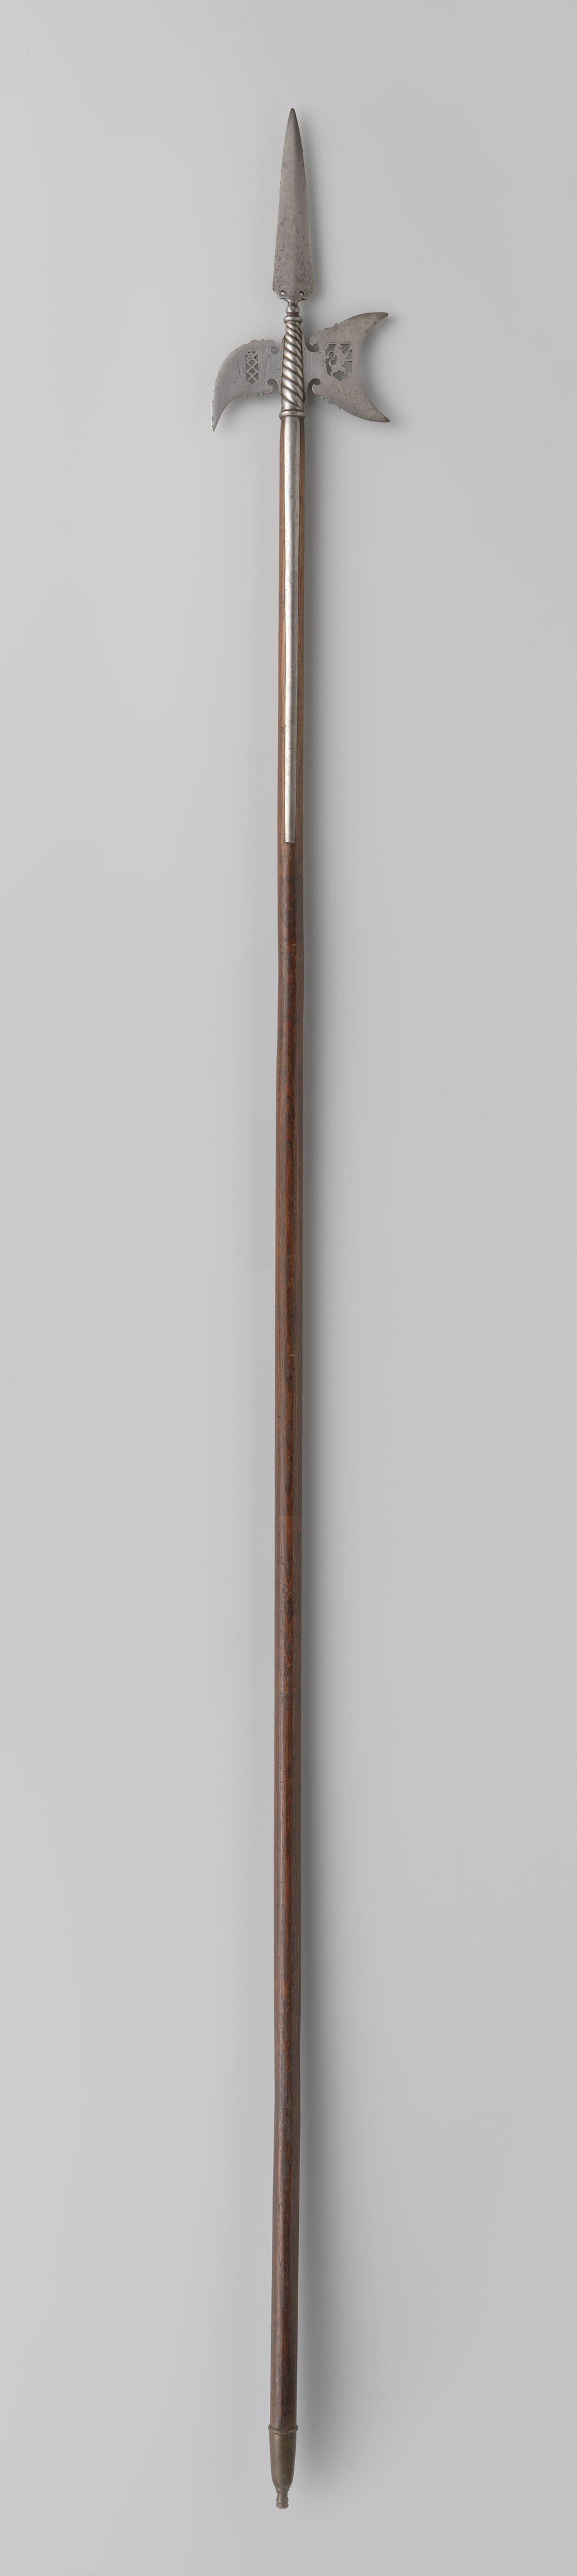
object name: halberd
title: Sergeantshellebaard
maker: Anonymous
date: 1600-1699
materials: iron, wood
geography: low countries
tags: europe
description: Korte kling met een sterke taps toelopende vorm; onderin twee doorboringen. Taps toelopend gedraaid huis met twee ringvormig profielen boven en onder. Het huis heeft een dwars doorgaande spleet waar de bijl en haak doorheen zijn gestoken. Zowel de bijl als de haak zijn ajourgewerkt. In de bijl is een primitieve staande leeuw uitgesneden, in de haak een decoratief ruitvormig motief. Twee aangeklonken veren. Ronde stok met schoen.